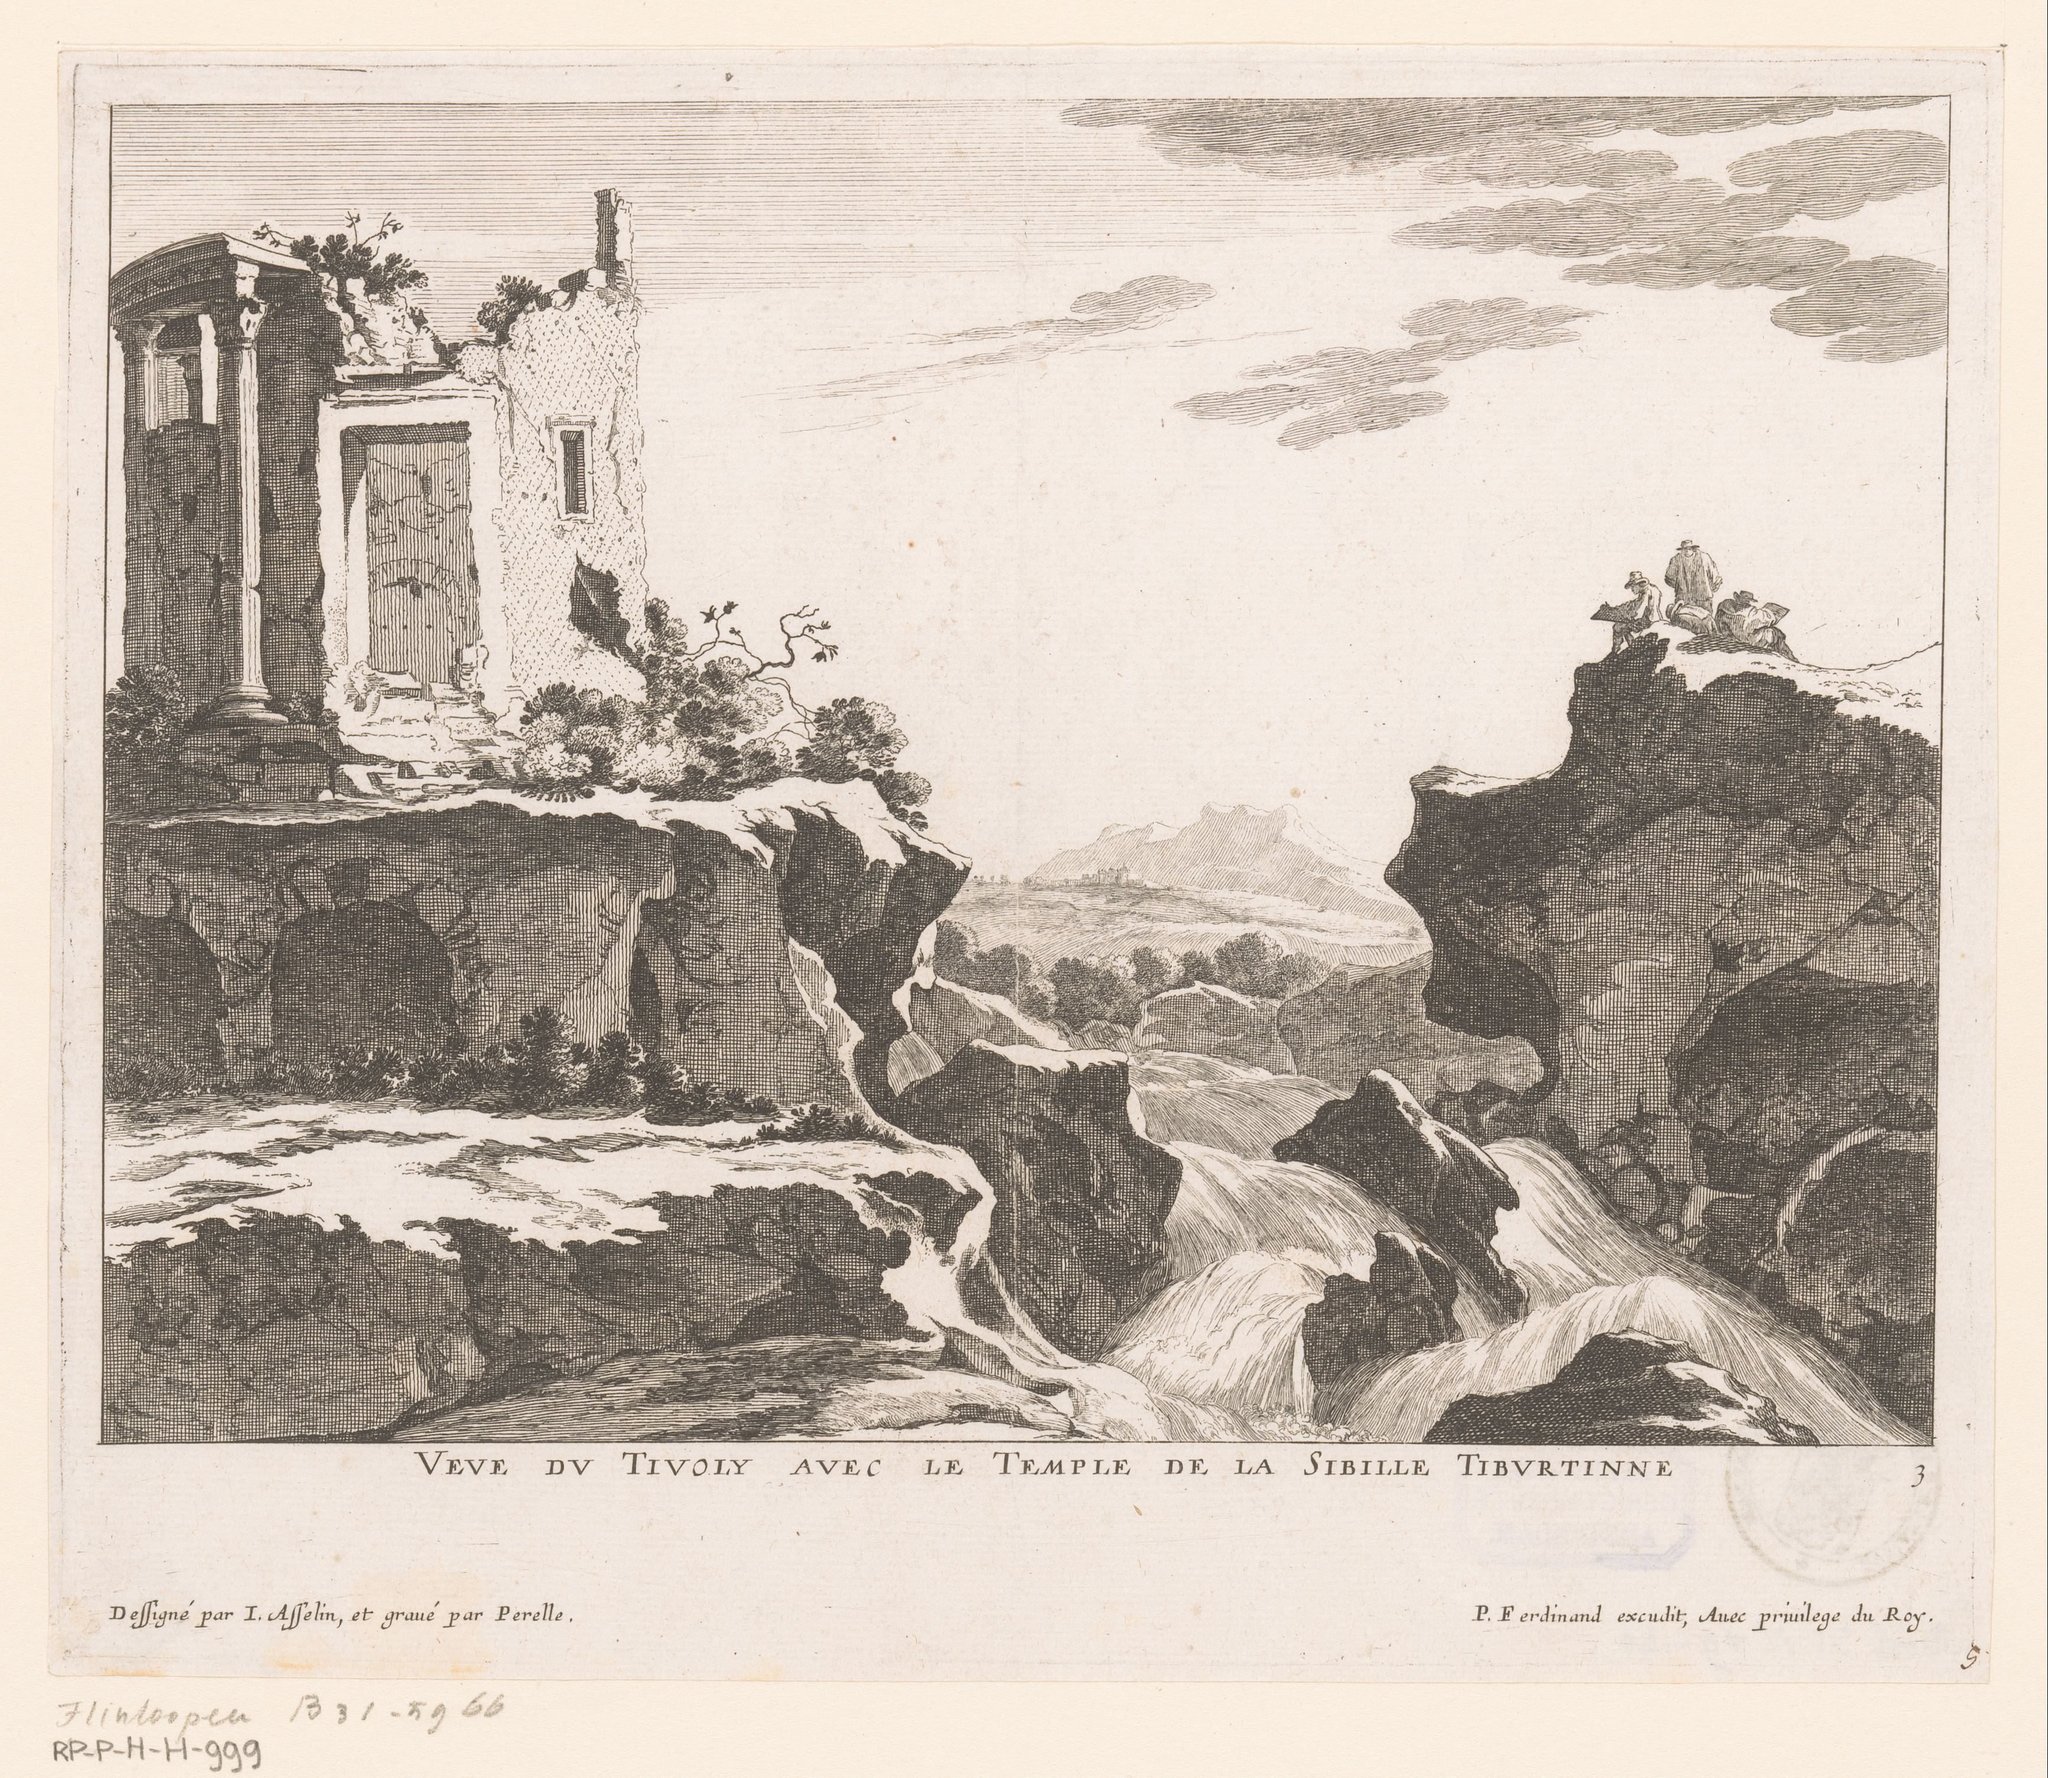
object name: print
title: Kunstenaars aan het werk bij rivier bij ruïne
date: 1627-1655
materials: paper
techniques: engraving, etching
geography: france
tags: landscape with ruins (+ city(-scape) with figures, staffage), artist at work, in his workshop - bb - out of doors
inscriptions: collector's mark: Lugt 10, collector's mark: Lugt 11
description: Prenten met het signatuur 'Perelle' kunnen zowel door vader Gabriel als door zonen Nicolas en Adam gemaakt zijn.